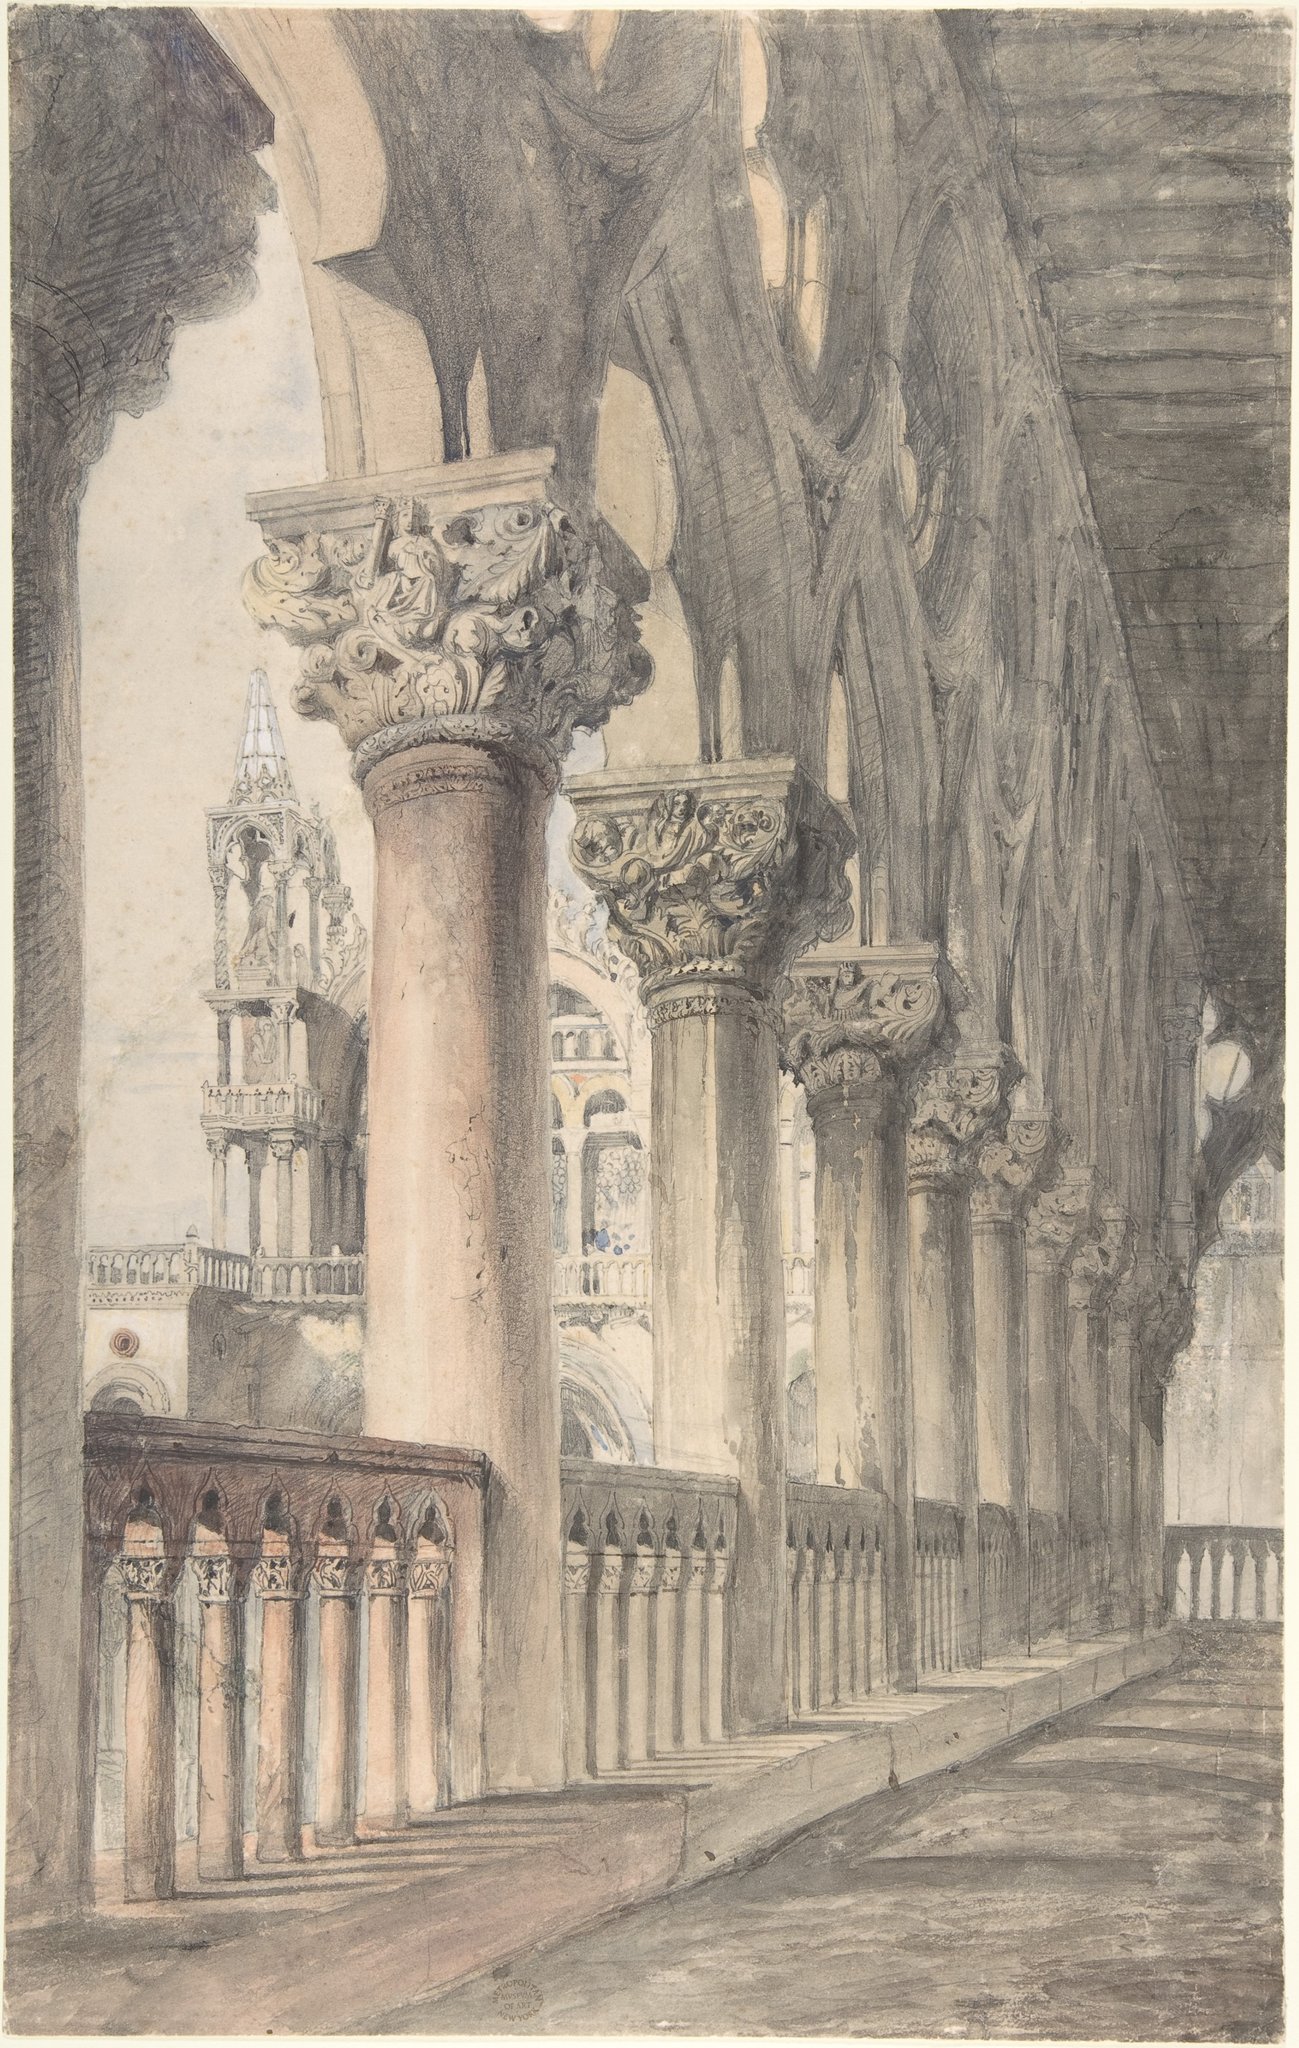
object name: drawing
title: Loggia of the Ducal Palace, Venice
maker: john ruskin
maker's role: artist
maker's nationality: british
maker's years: 1819-1900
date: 1849-1850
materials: graphite, watercolor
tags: architecture,columns,venice